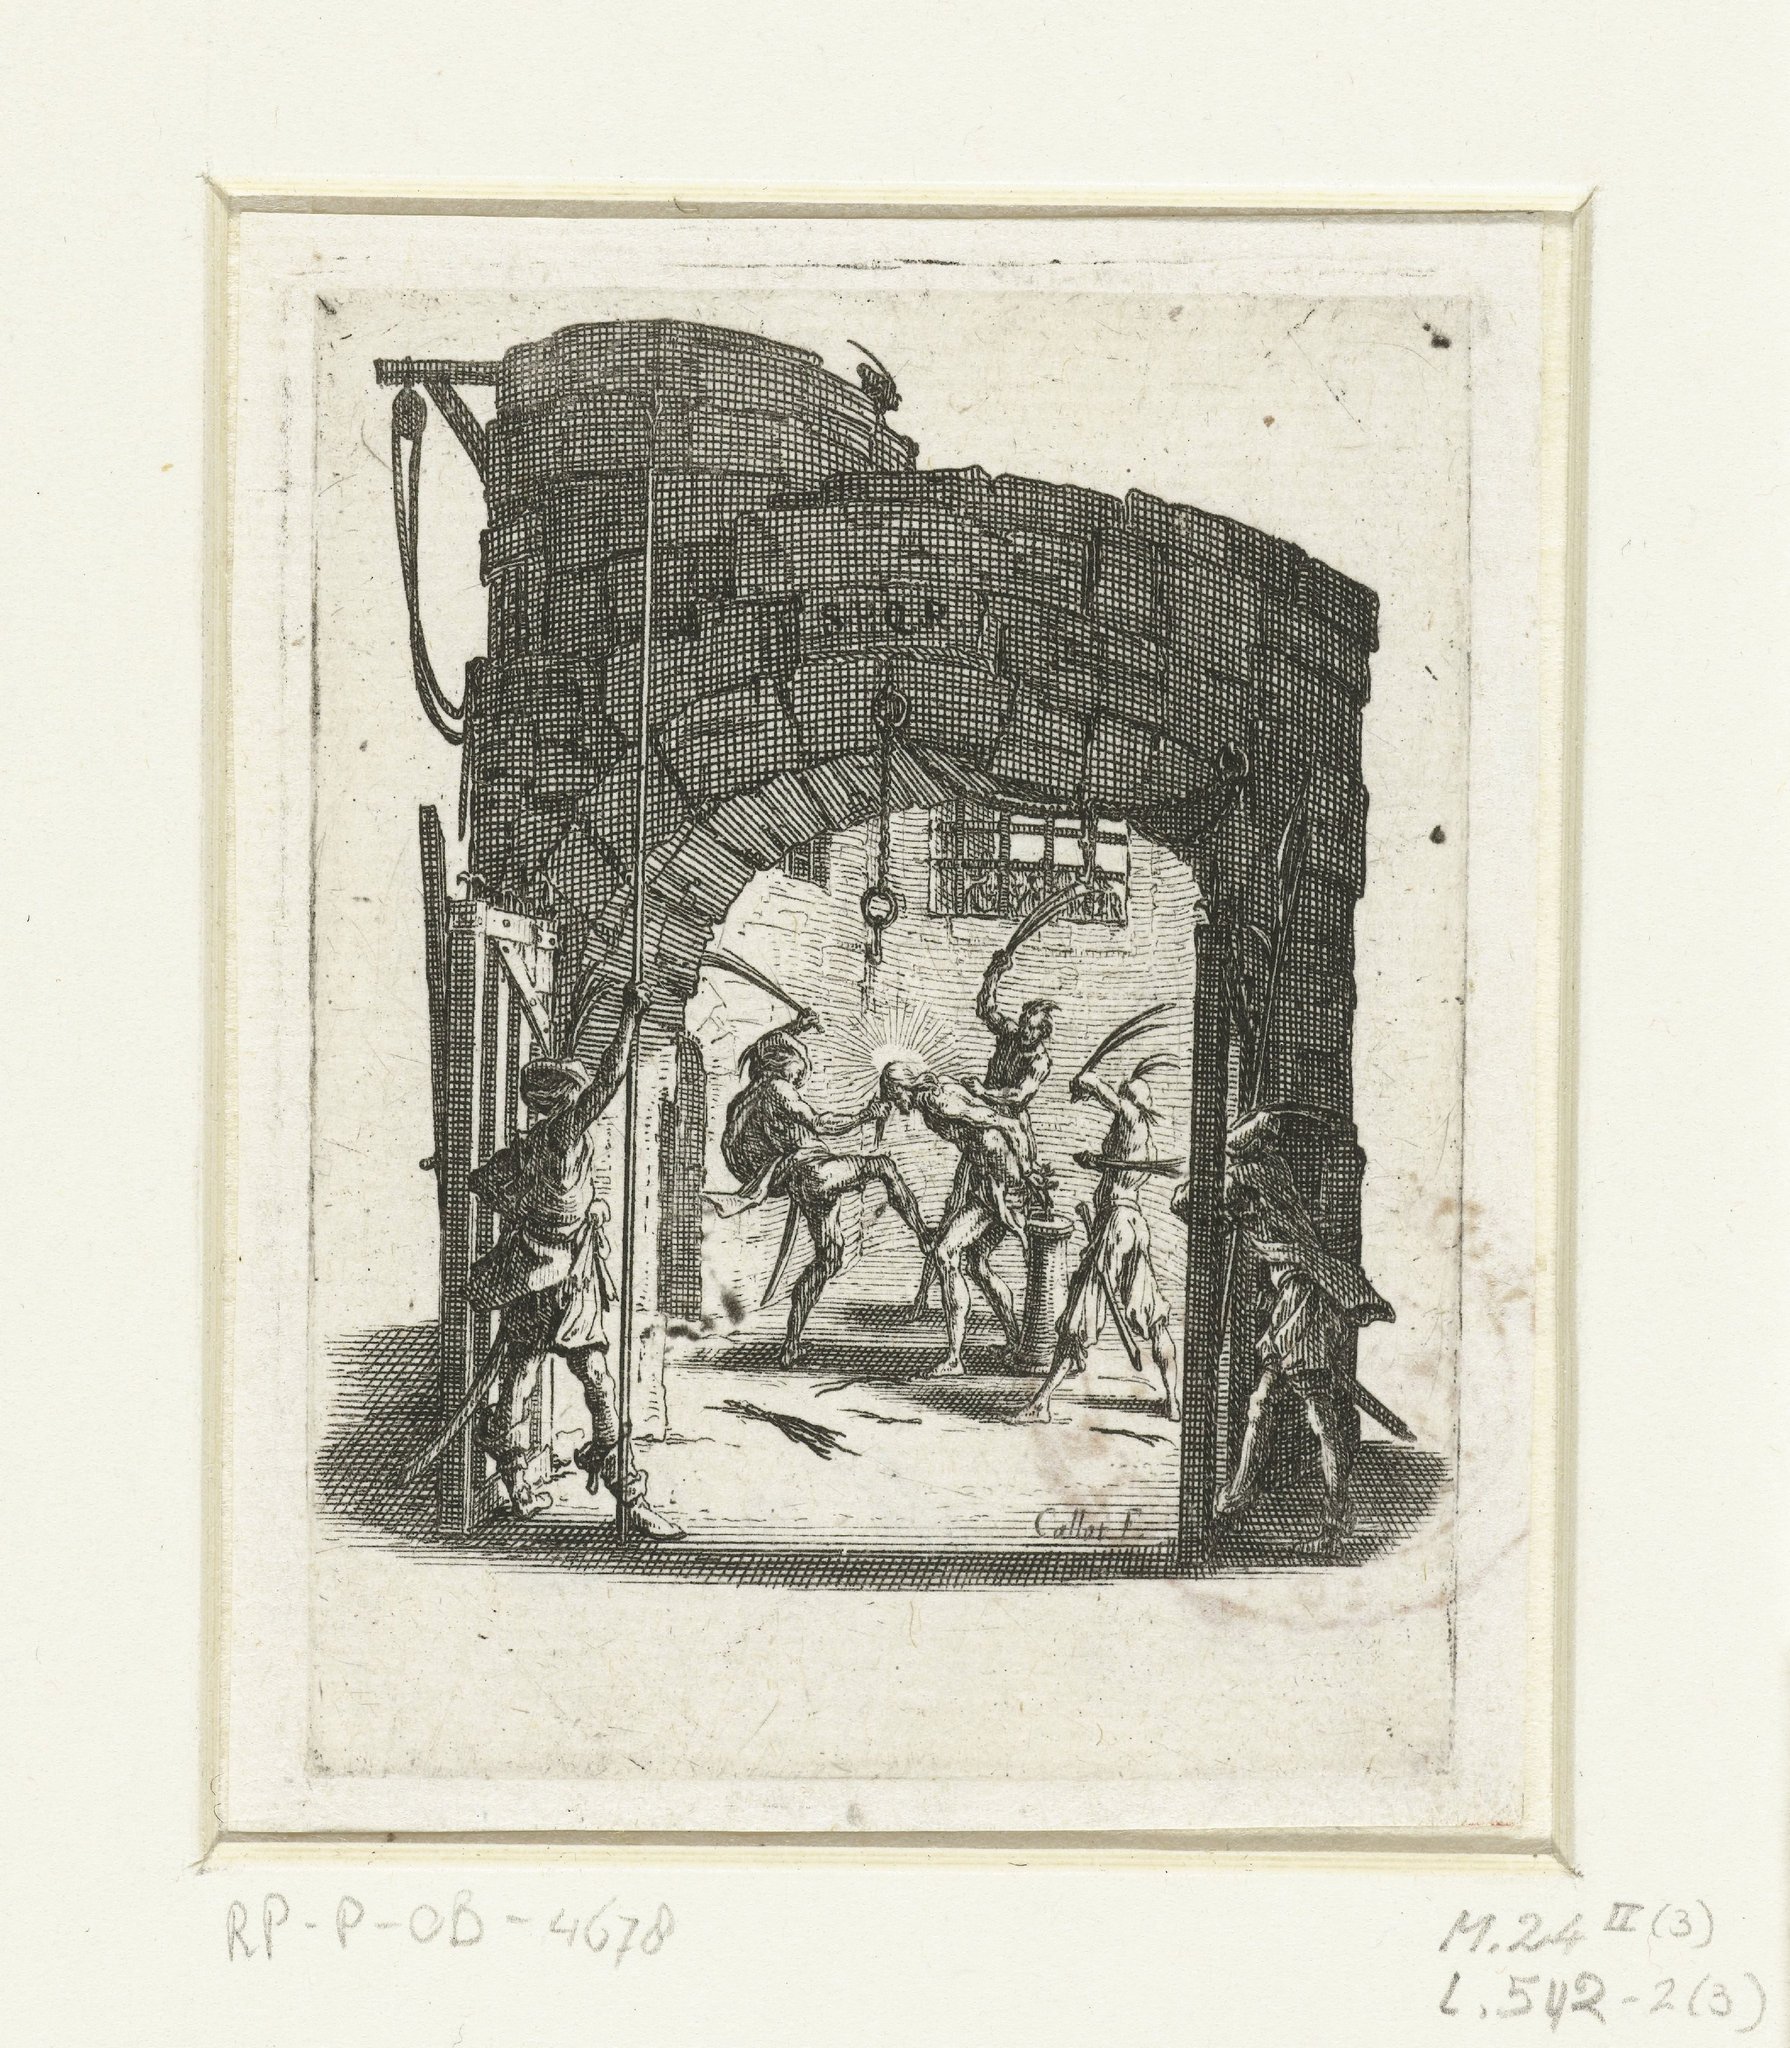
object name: print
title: De kleine Passie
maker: jacques callot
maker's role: draughtsman, print maker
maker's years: 1592-1635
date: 1624-1625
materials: paper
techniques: etching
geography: nancy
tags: flagellation by soldiers, christ usually tied to a column (matthew 27:26; mark 15:15; john 19:1)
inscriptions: collector's mark: Lugt 240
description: Christus, gebonden aan een pilaartje, wordt door drie mannen geslagen met takkenbossen. Deze prent is onderdeel van de prentserie 'De kleine Passie', bestaande uit 12 scènes uit het Lijdensverhaal.